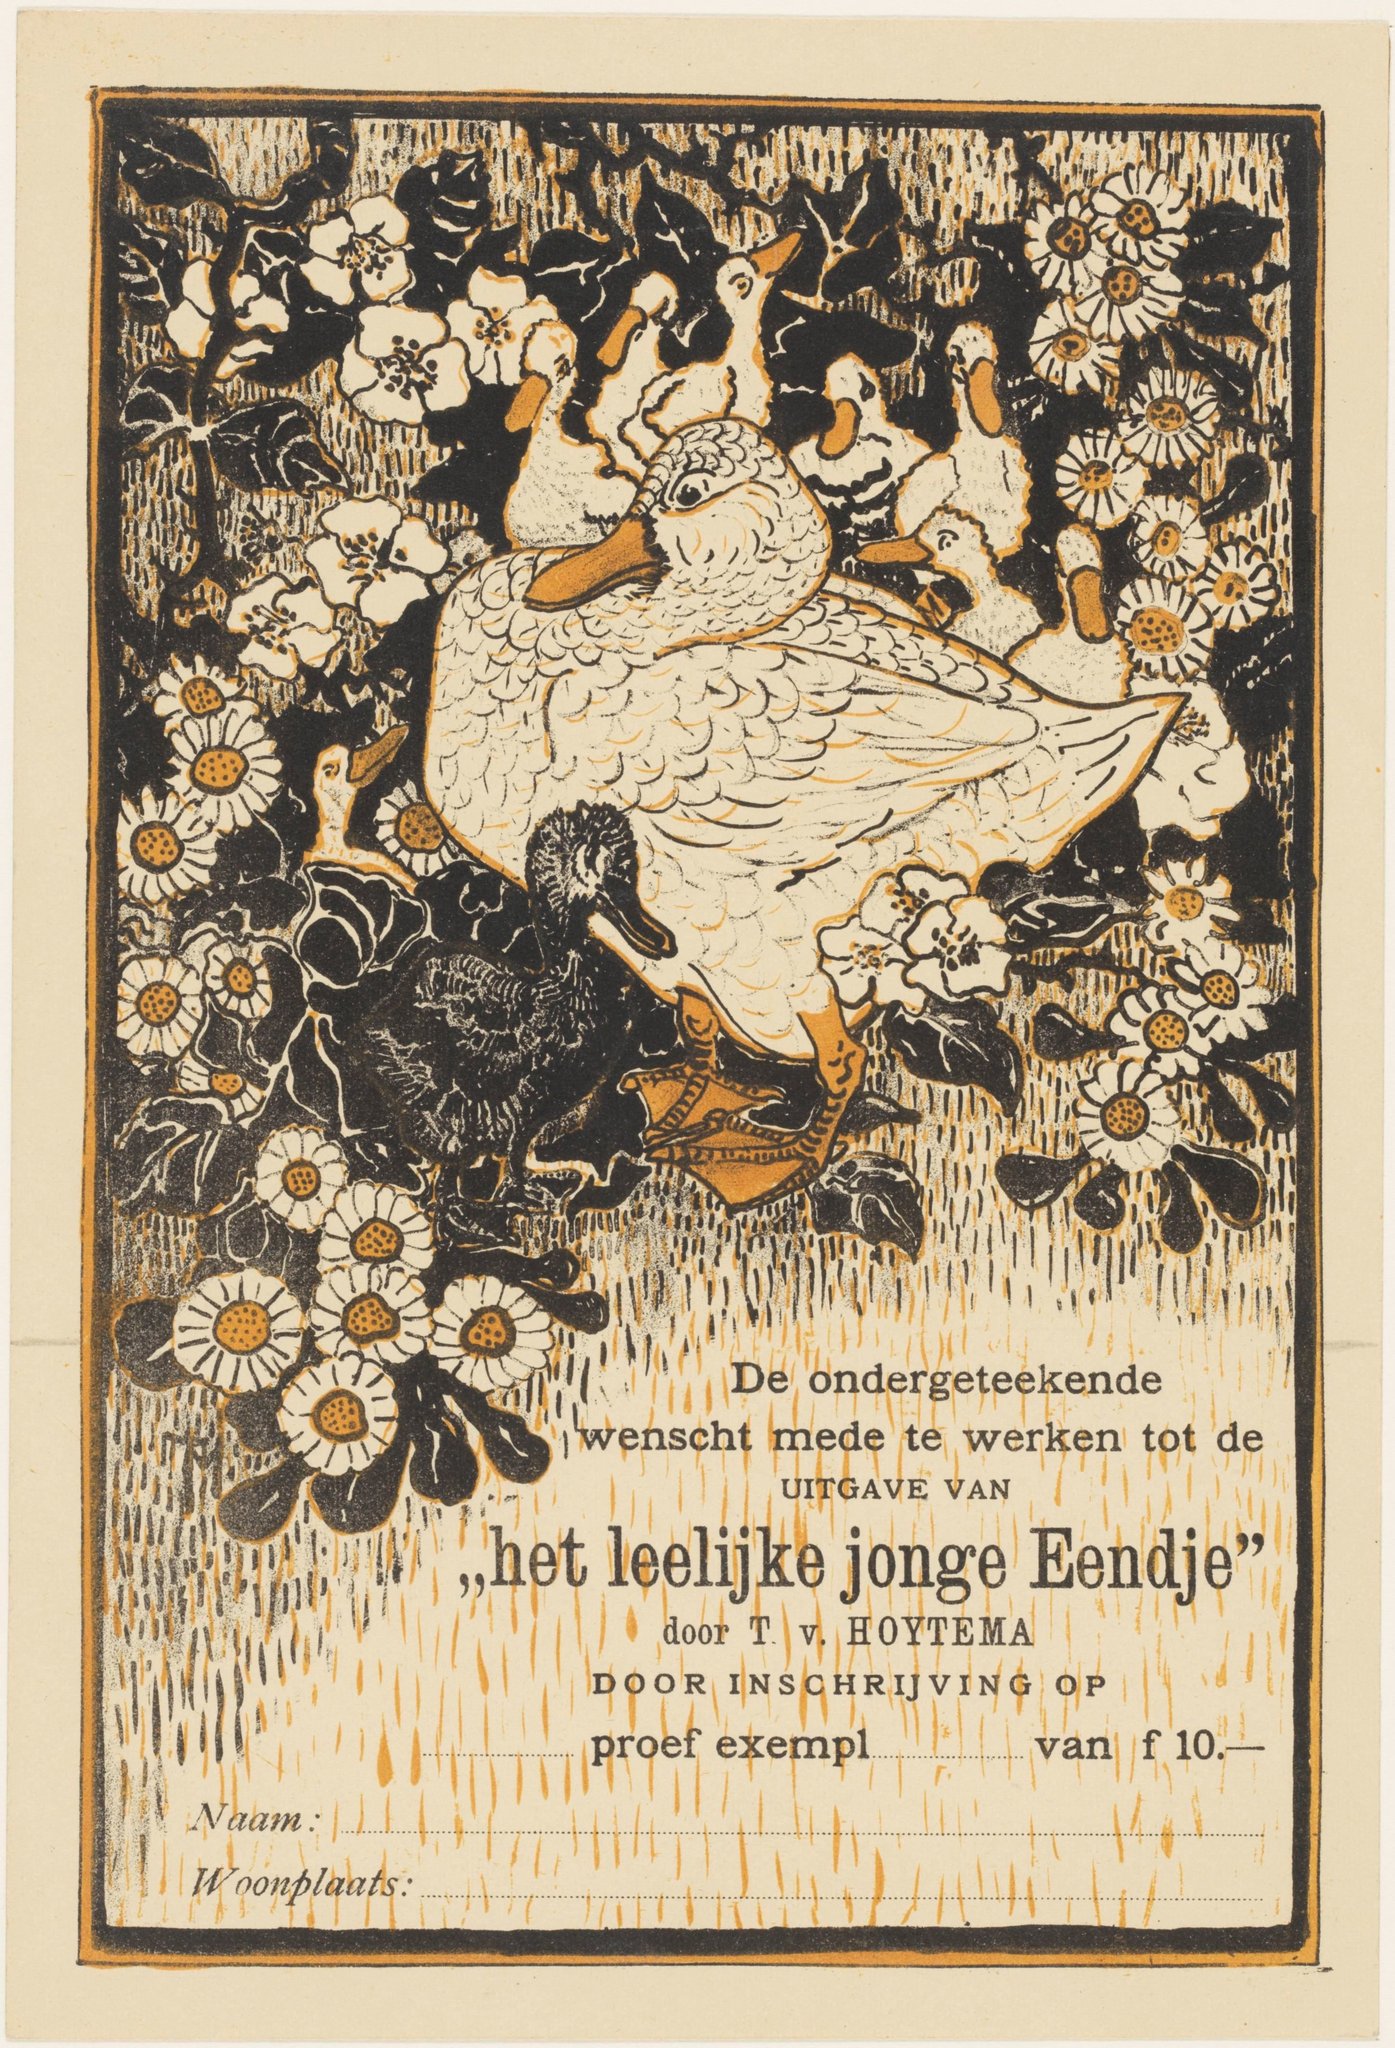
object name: print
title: Bestelkaart voor proefexemplaar van 'Het leelijke jonge eendje'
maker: theo van hoytema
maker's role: draughtsman, painter, print maker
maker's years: 1863-1917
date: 1893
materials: paper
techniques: letterpress printing, lithograph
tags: water-birds: duck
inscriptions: collector's mark: Lugt 2228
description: Een eend met negen kuikens omgeven door bloemen.